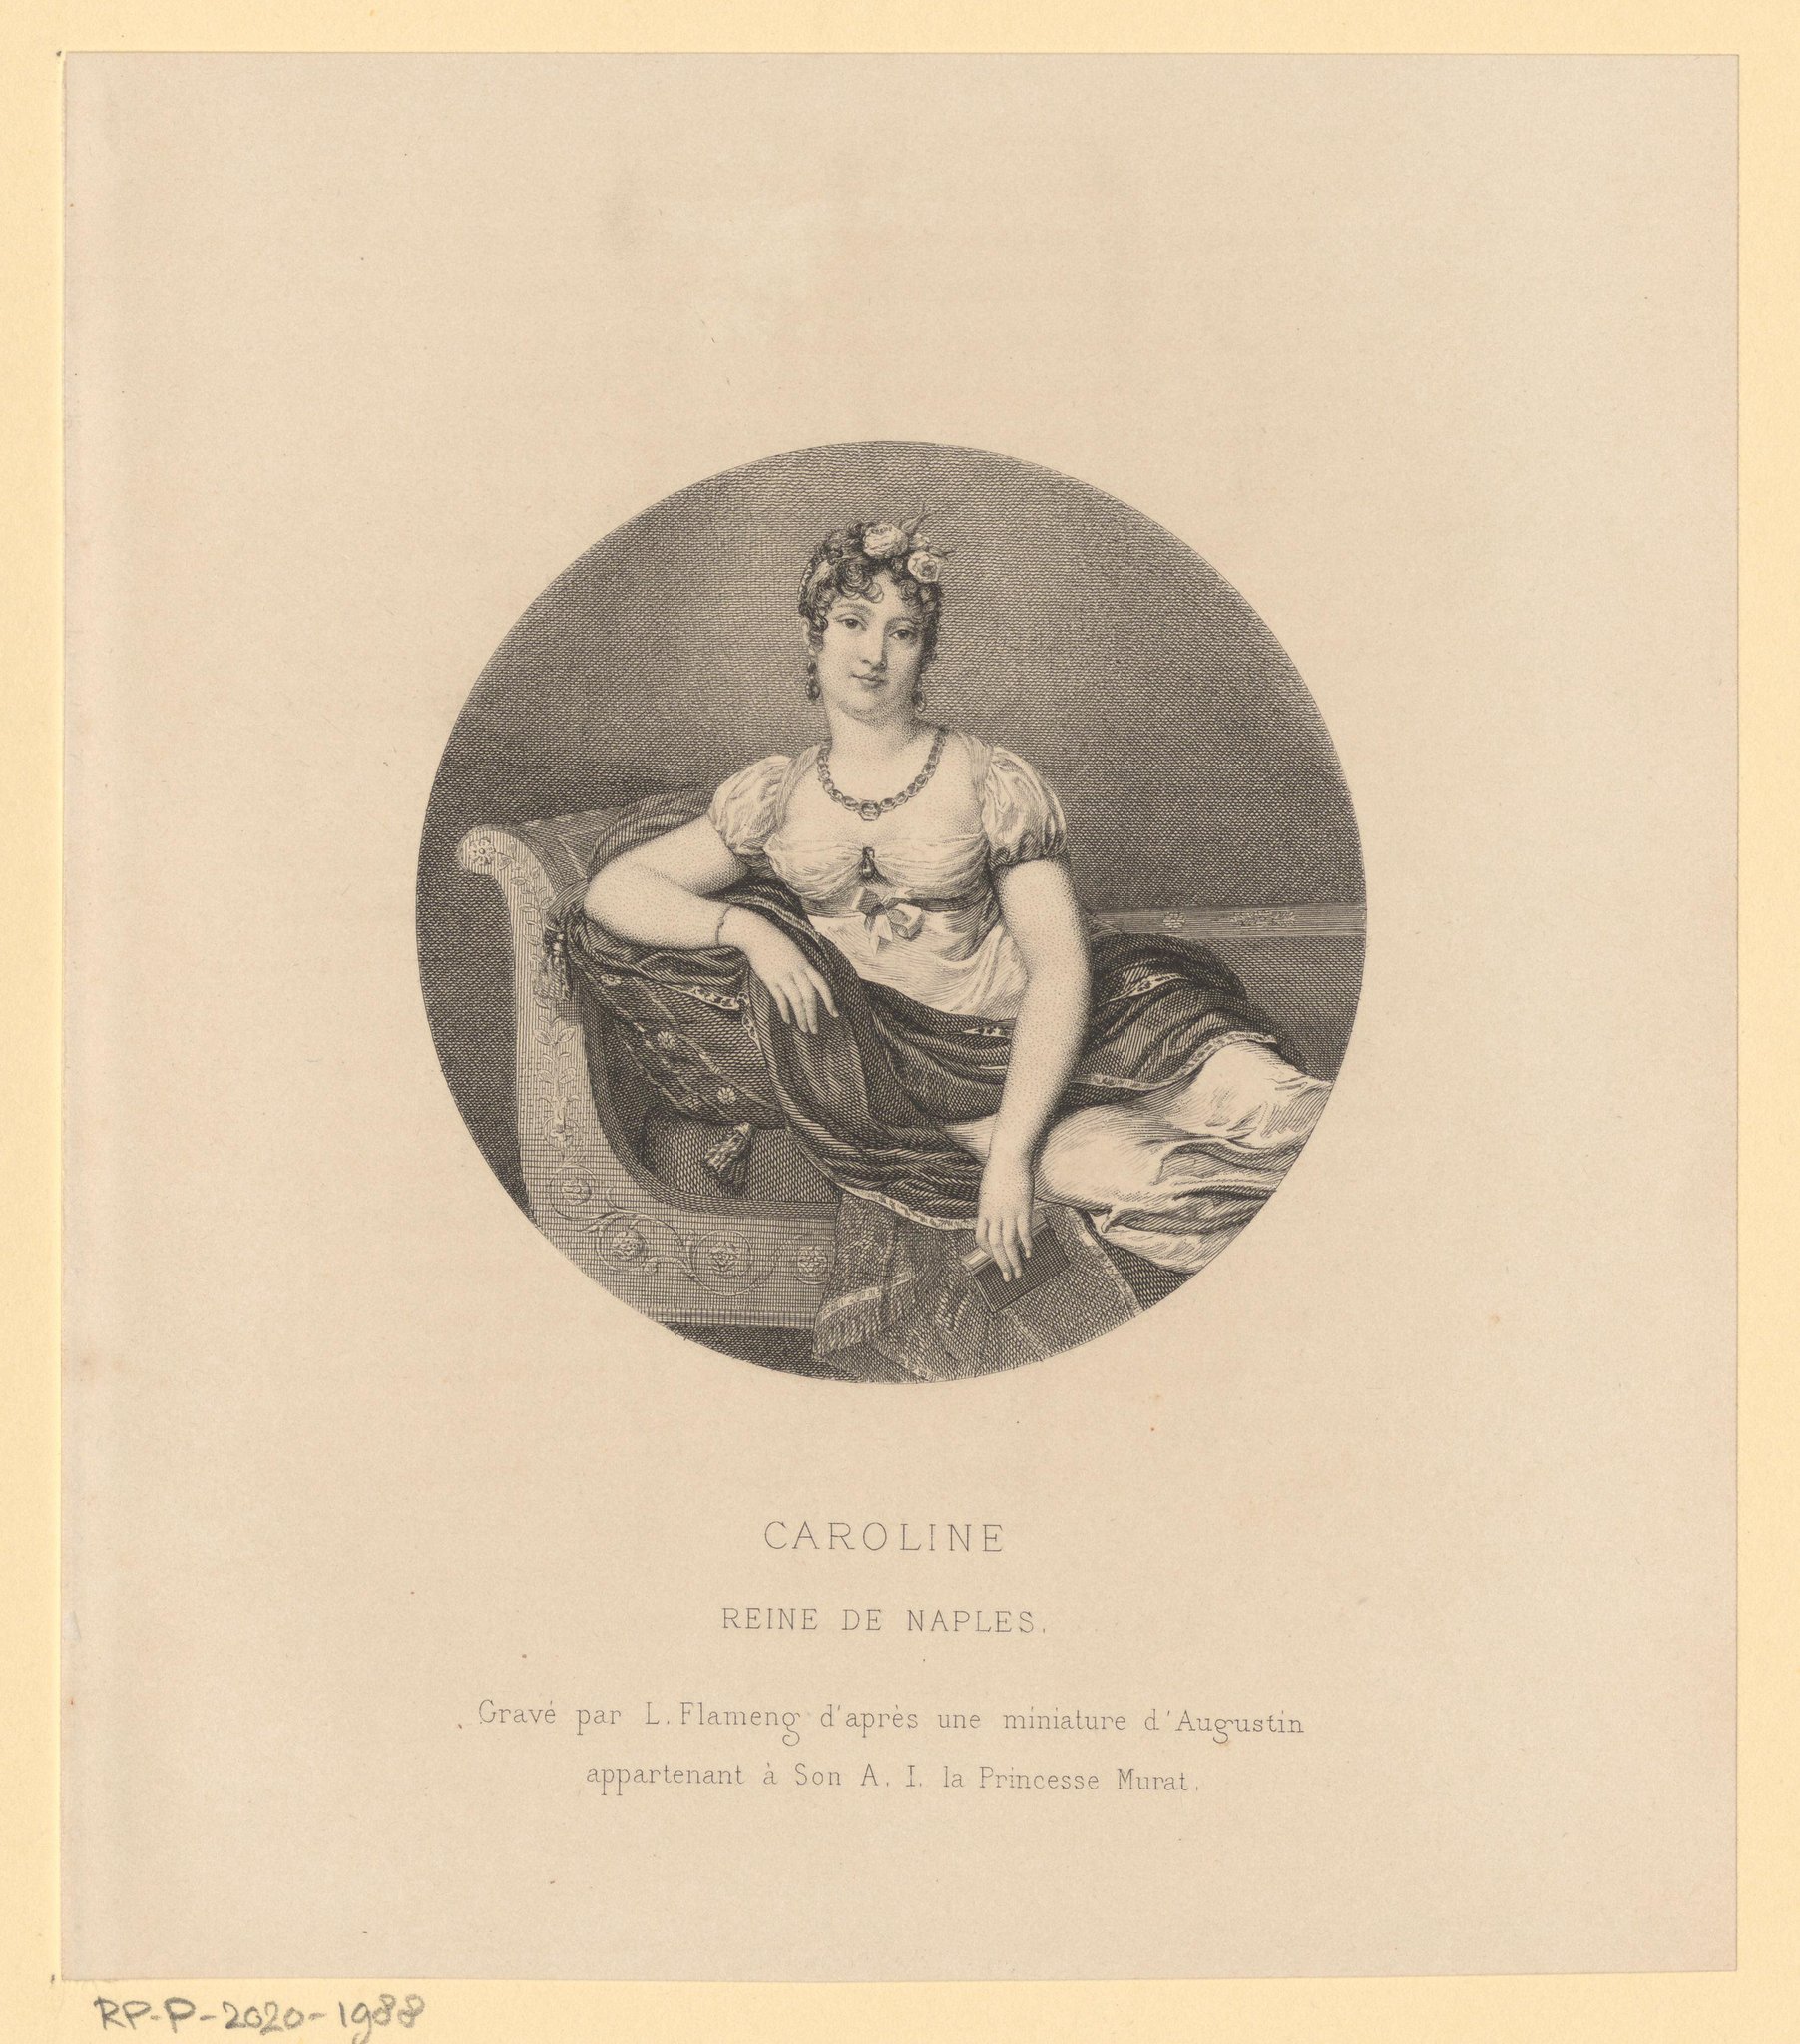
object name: print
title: Portret van Maria Annunciata (Carolina) Bonaparte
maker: léopold flameng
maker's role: print maker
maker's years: 1831-1911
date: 1841-1911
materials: paper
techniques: etching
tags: historical persons - bb - woman